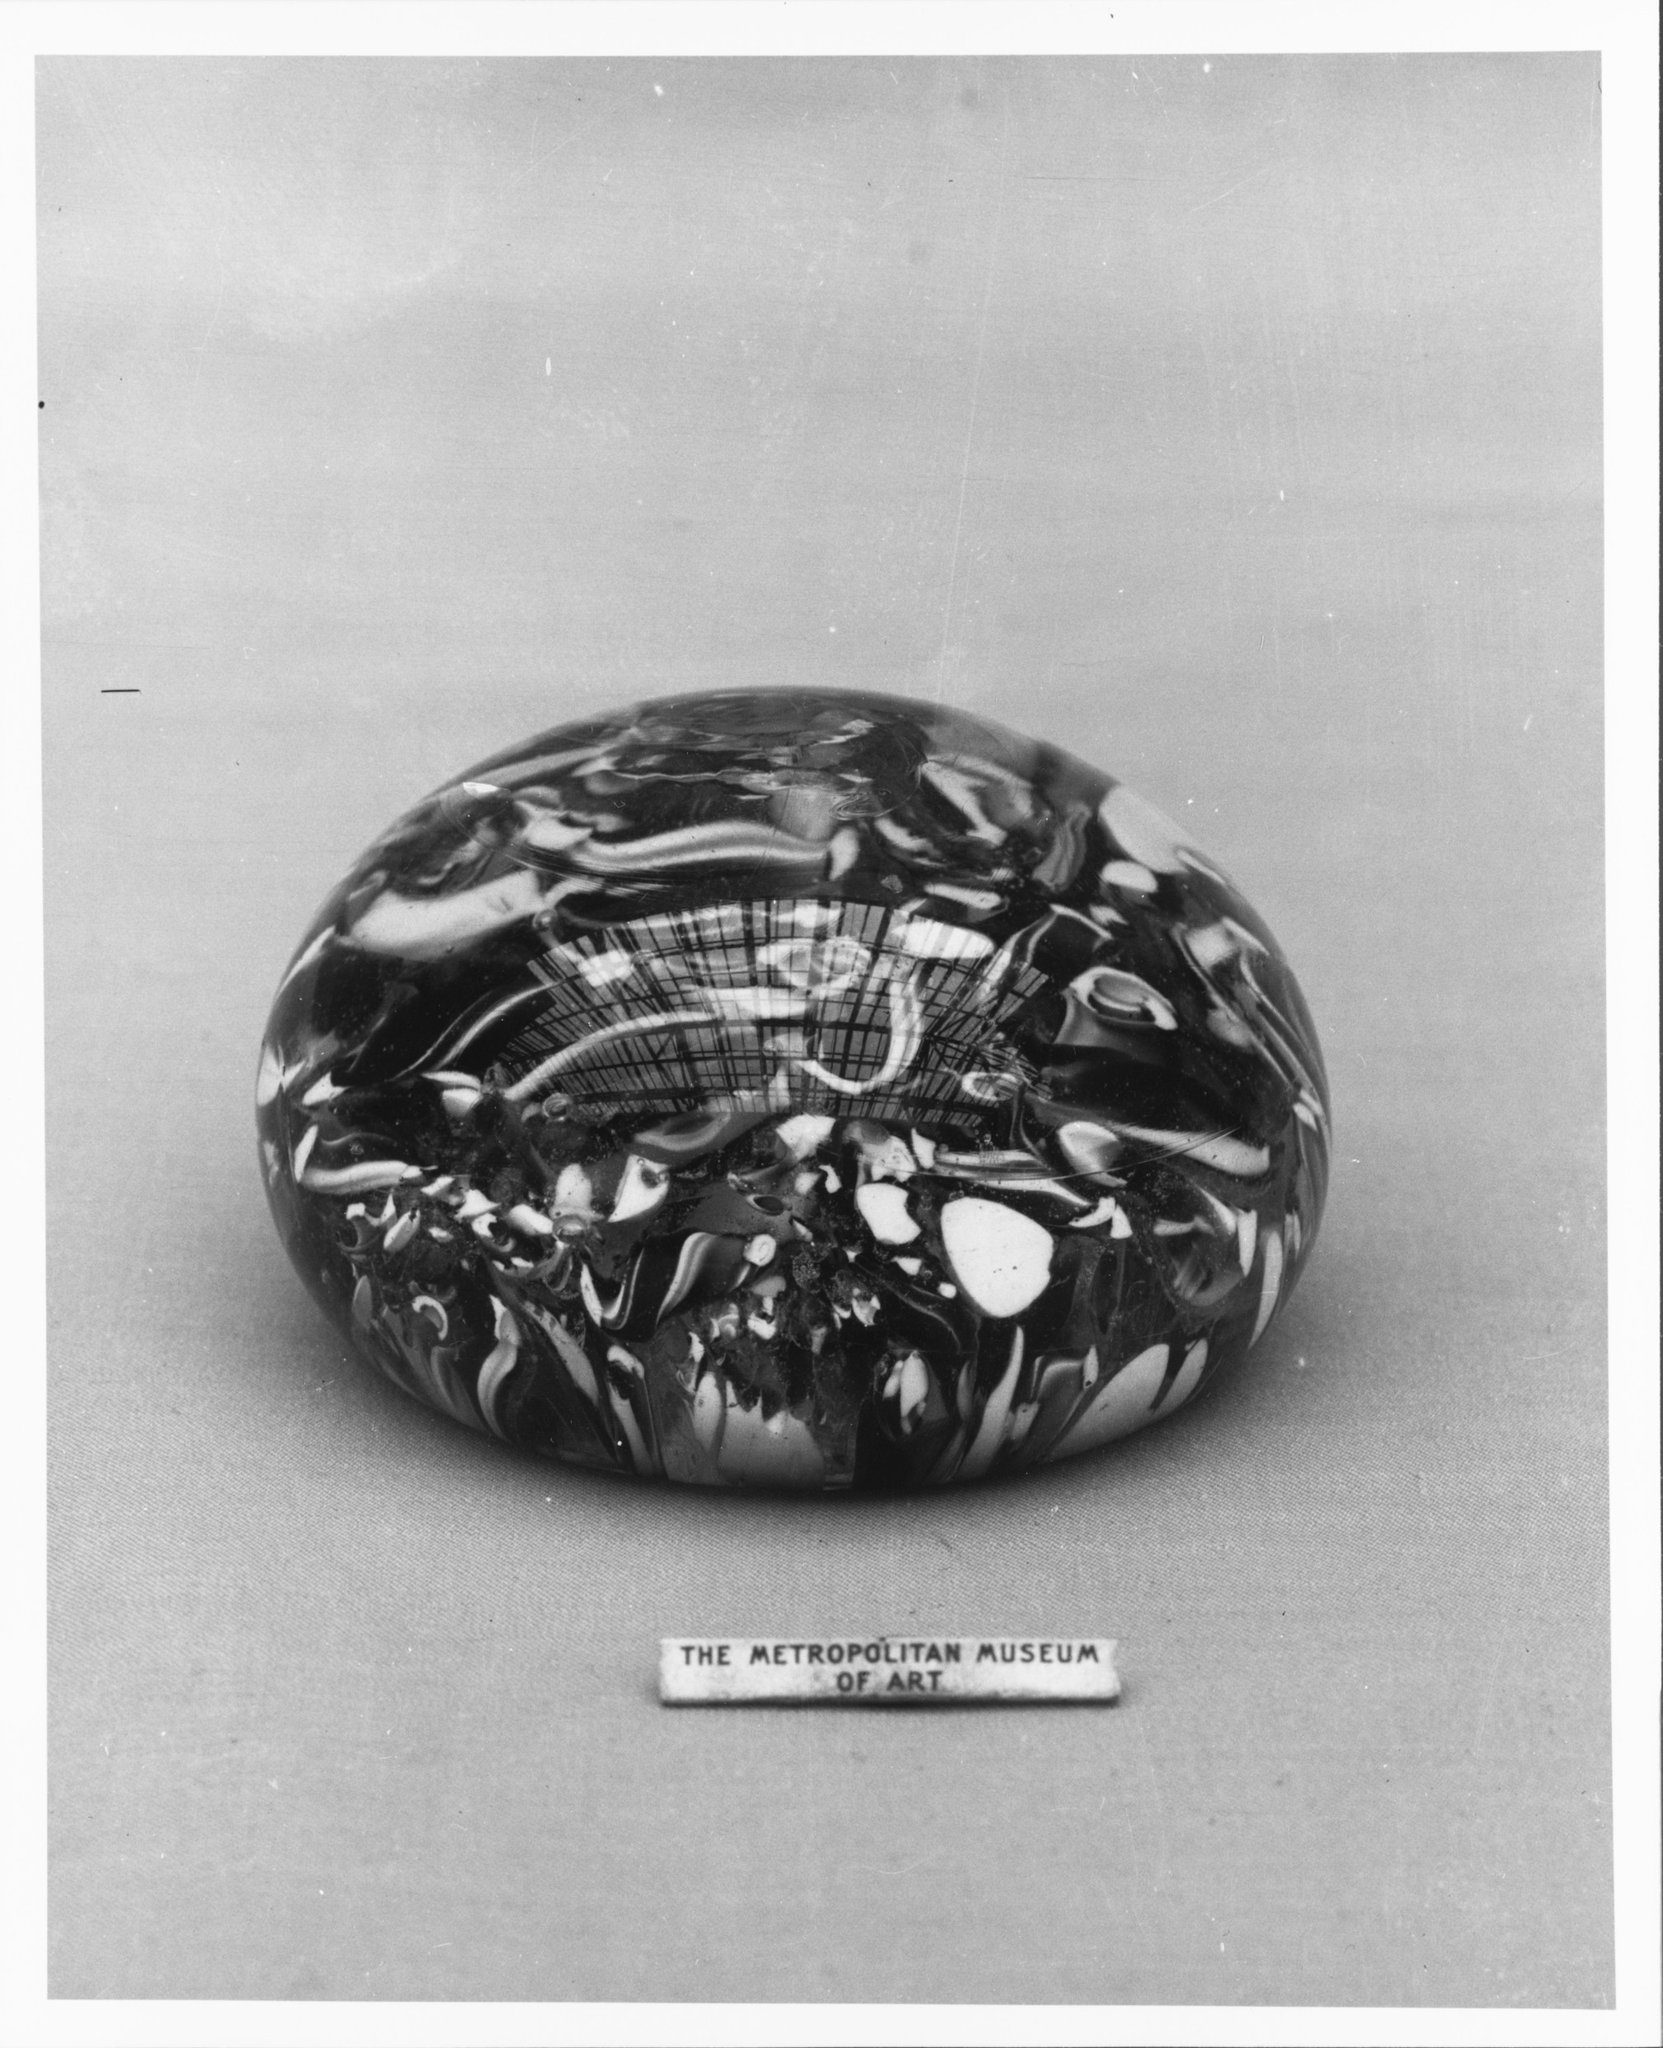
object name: paperweight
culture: french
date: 1850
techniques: glassblowing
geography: france